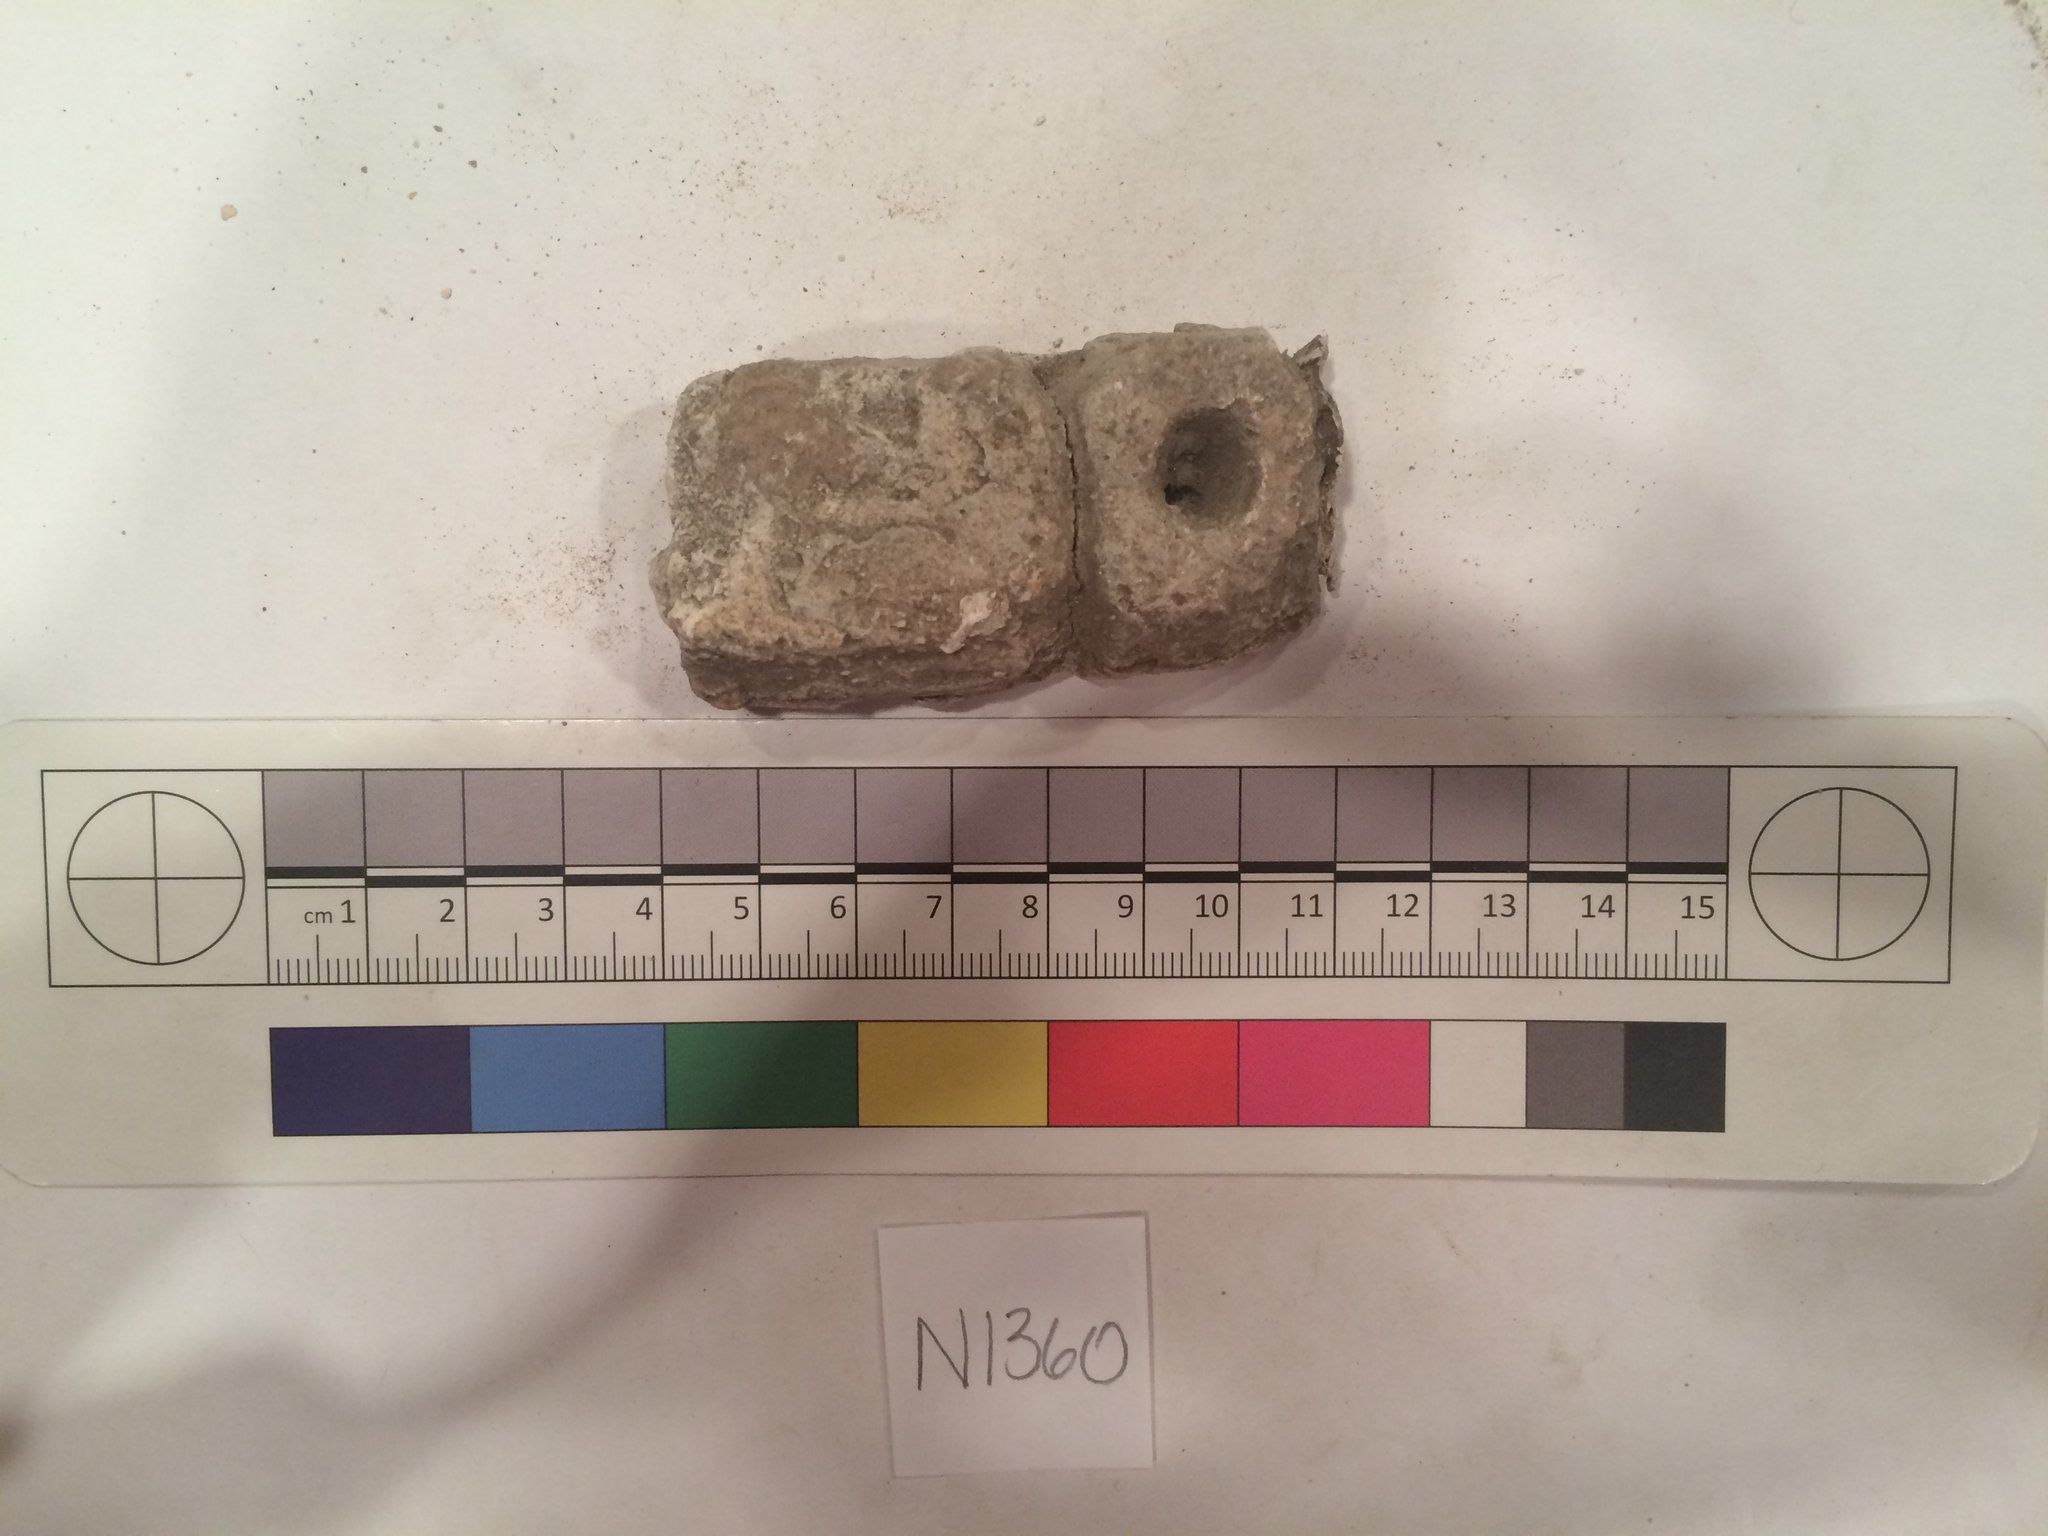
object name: fragment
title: Stucco Fragment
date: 701-1200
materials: plaster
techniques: carving, painting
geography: iran